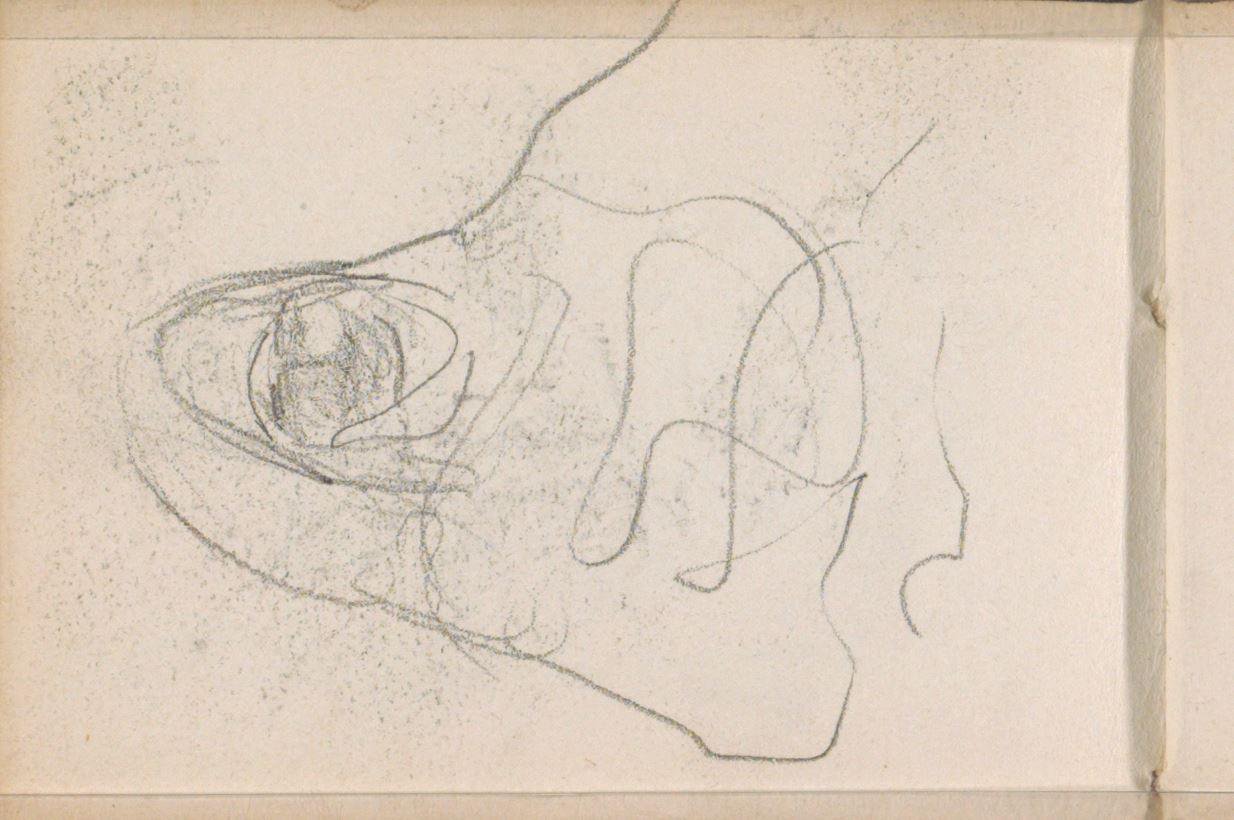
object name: sketchbook leaf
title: Figuur met hoofddoek, ten halven lijve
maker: marius bauer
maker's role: draughtsman, print maker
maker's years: 1867-1932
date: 1922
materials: paper, pencil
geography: biskra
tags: head-gear (with name), africans, folk costume, regional costume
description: Pagina 10 uit een schetsboek met 32 bladen.